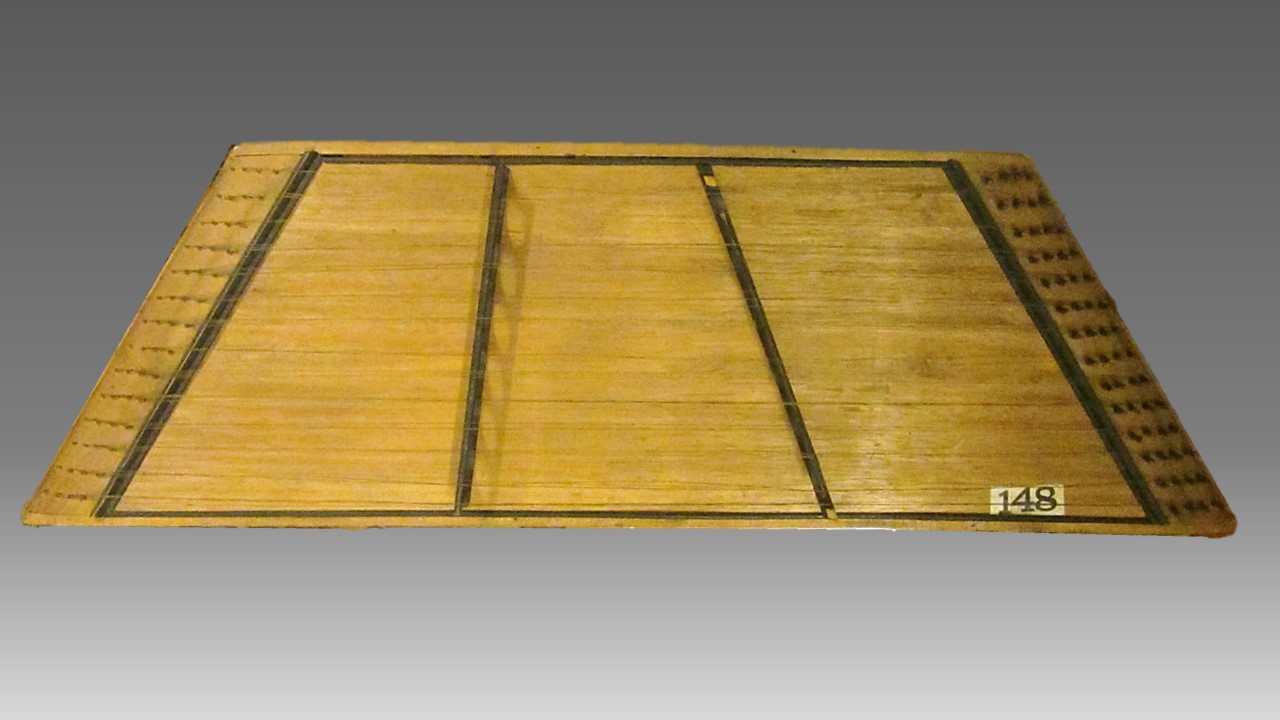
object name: yanggum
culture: korean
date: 1801-1900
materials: metal, wood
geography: korea